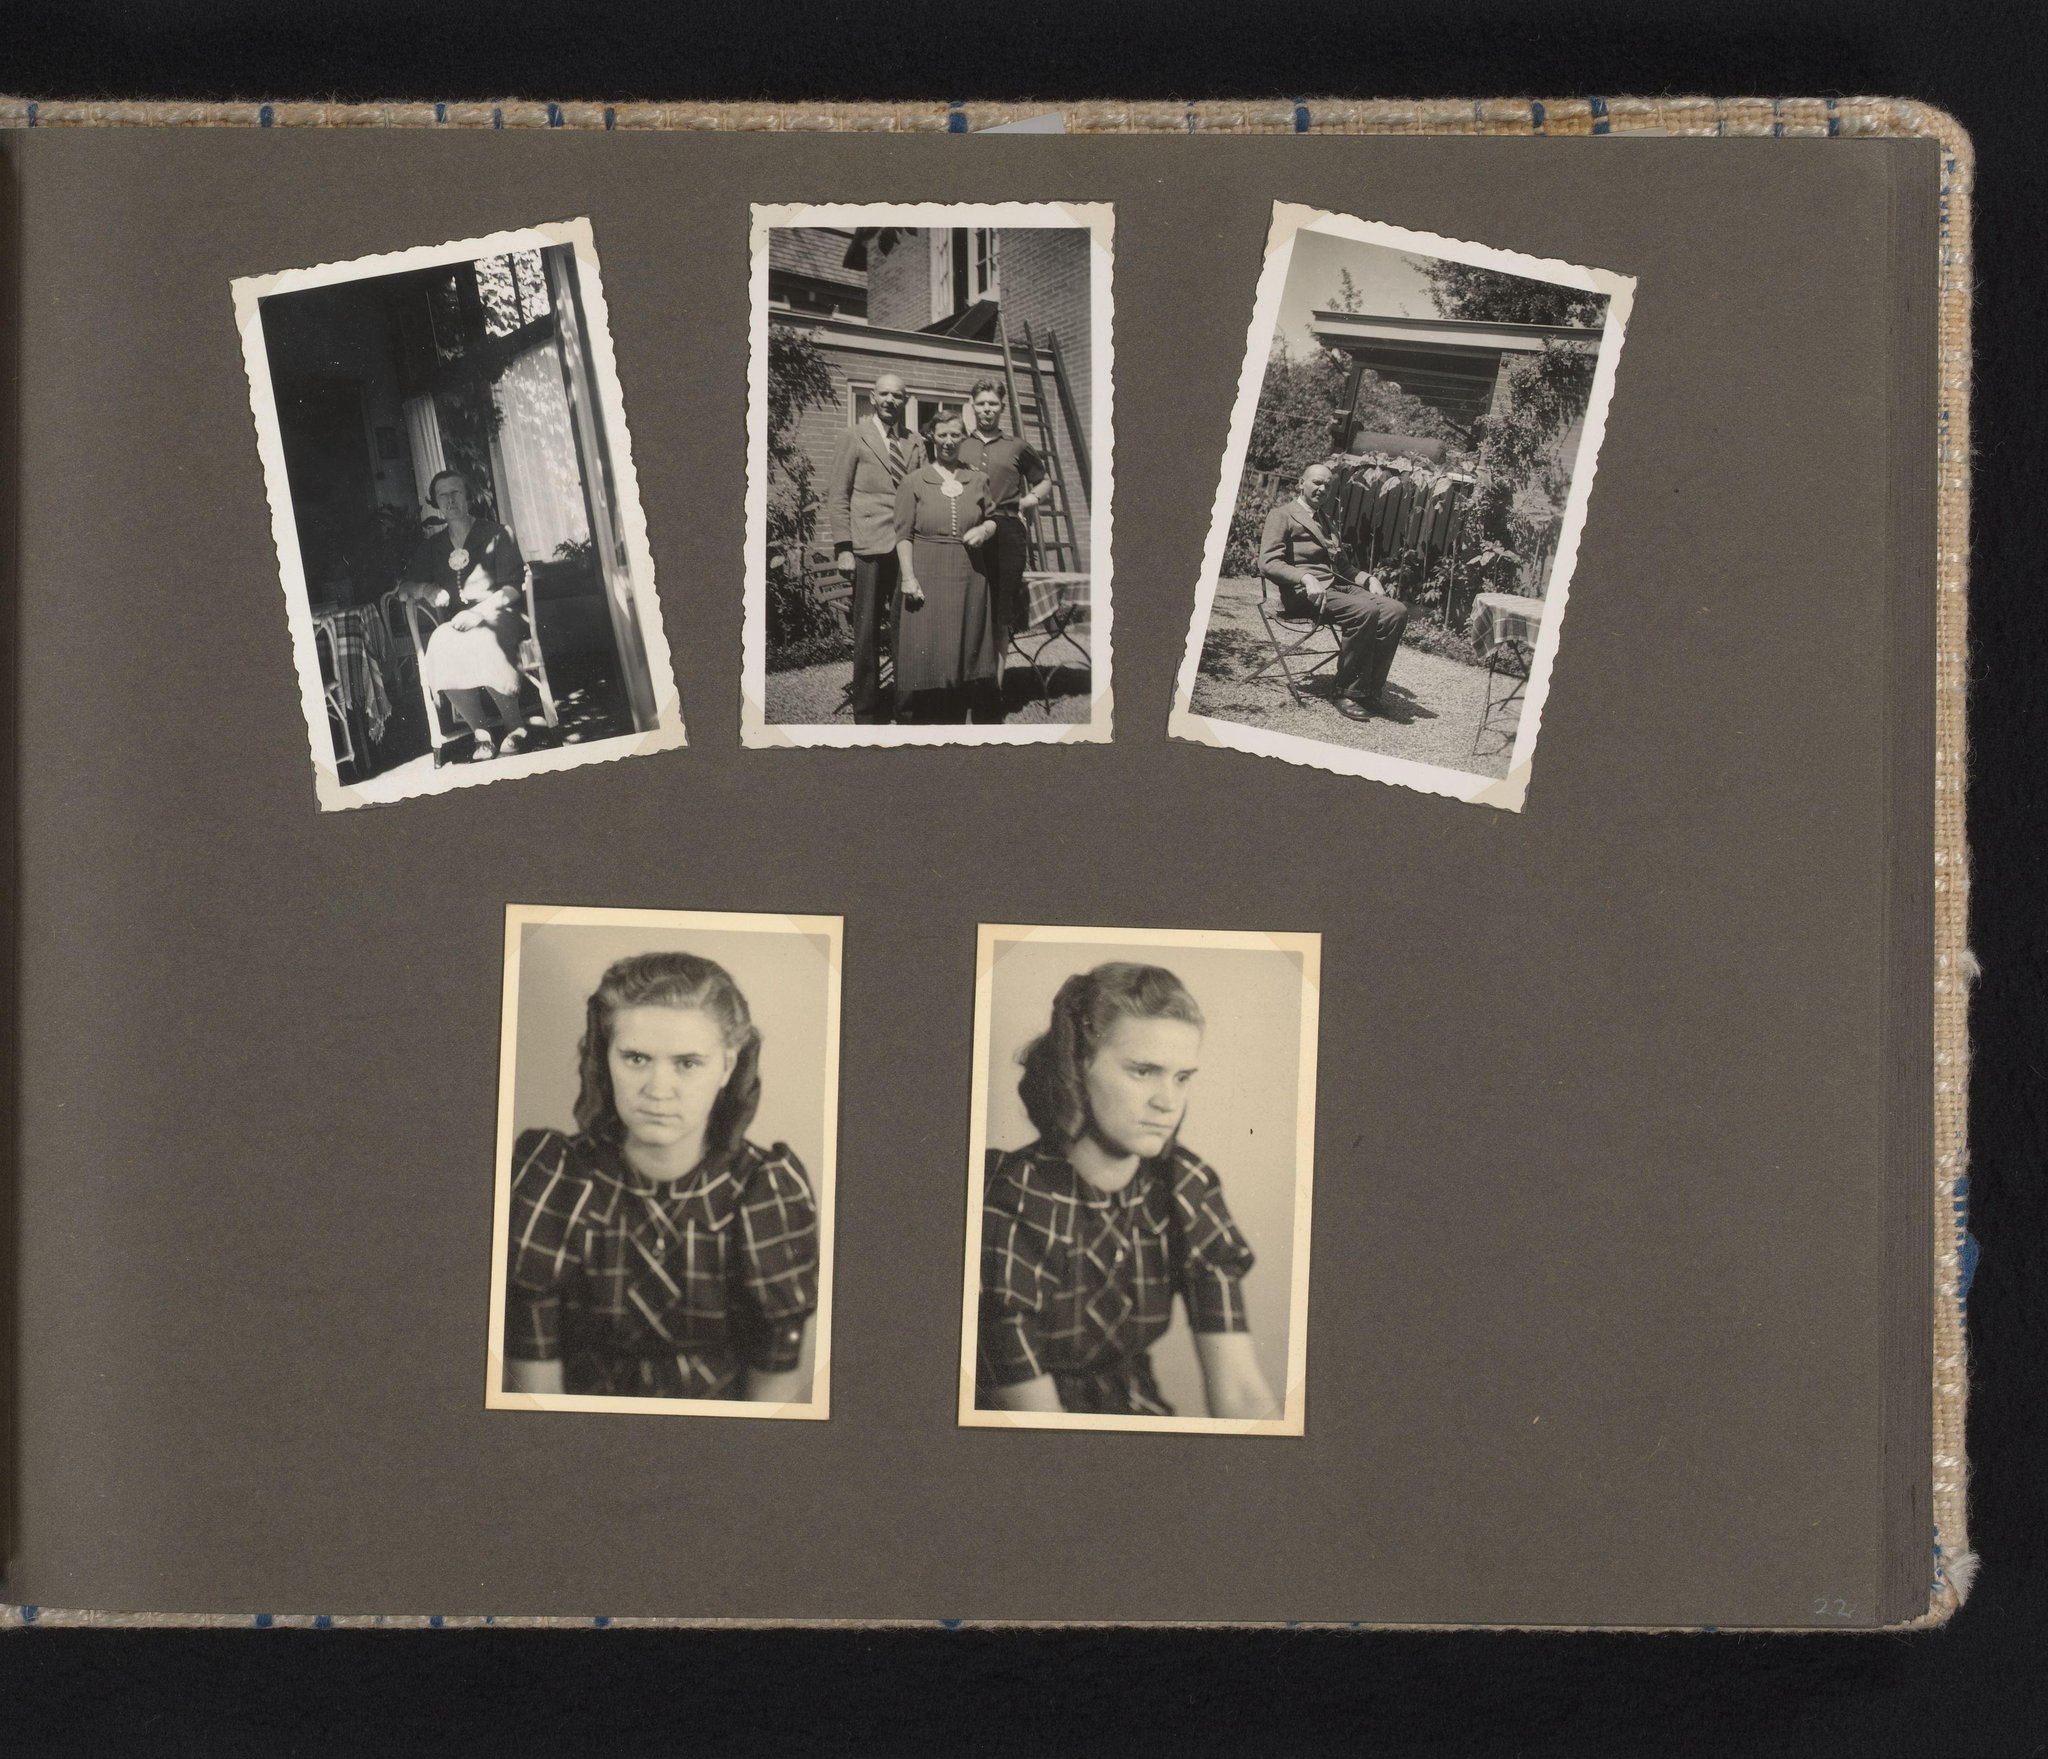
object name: album leaf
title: Familie en vrienden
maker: Anonymous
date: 1941-1942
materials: cardboard, photographic support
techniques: gelatin silver print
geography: netherlands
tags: the soldier off duty, street, occupation ~ war, netherlands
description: Albumblad met vijf foto's van familie en vrienden en portretten van een jonge vrouw. Onderdeel van het fotoalbum Abrechnungsintendantur van de Wehrmacht 1941-1943.